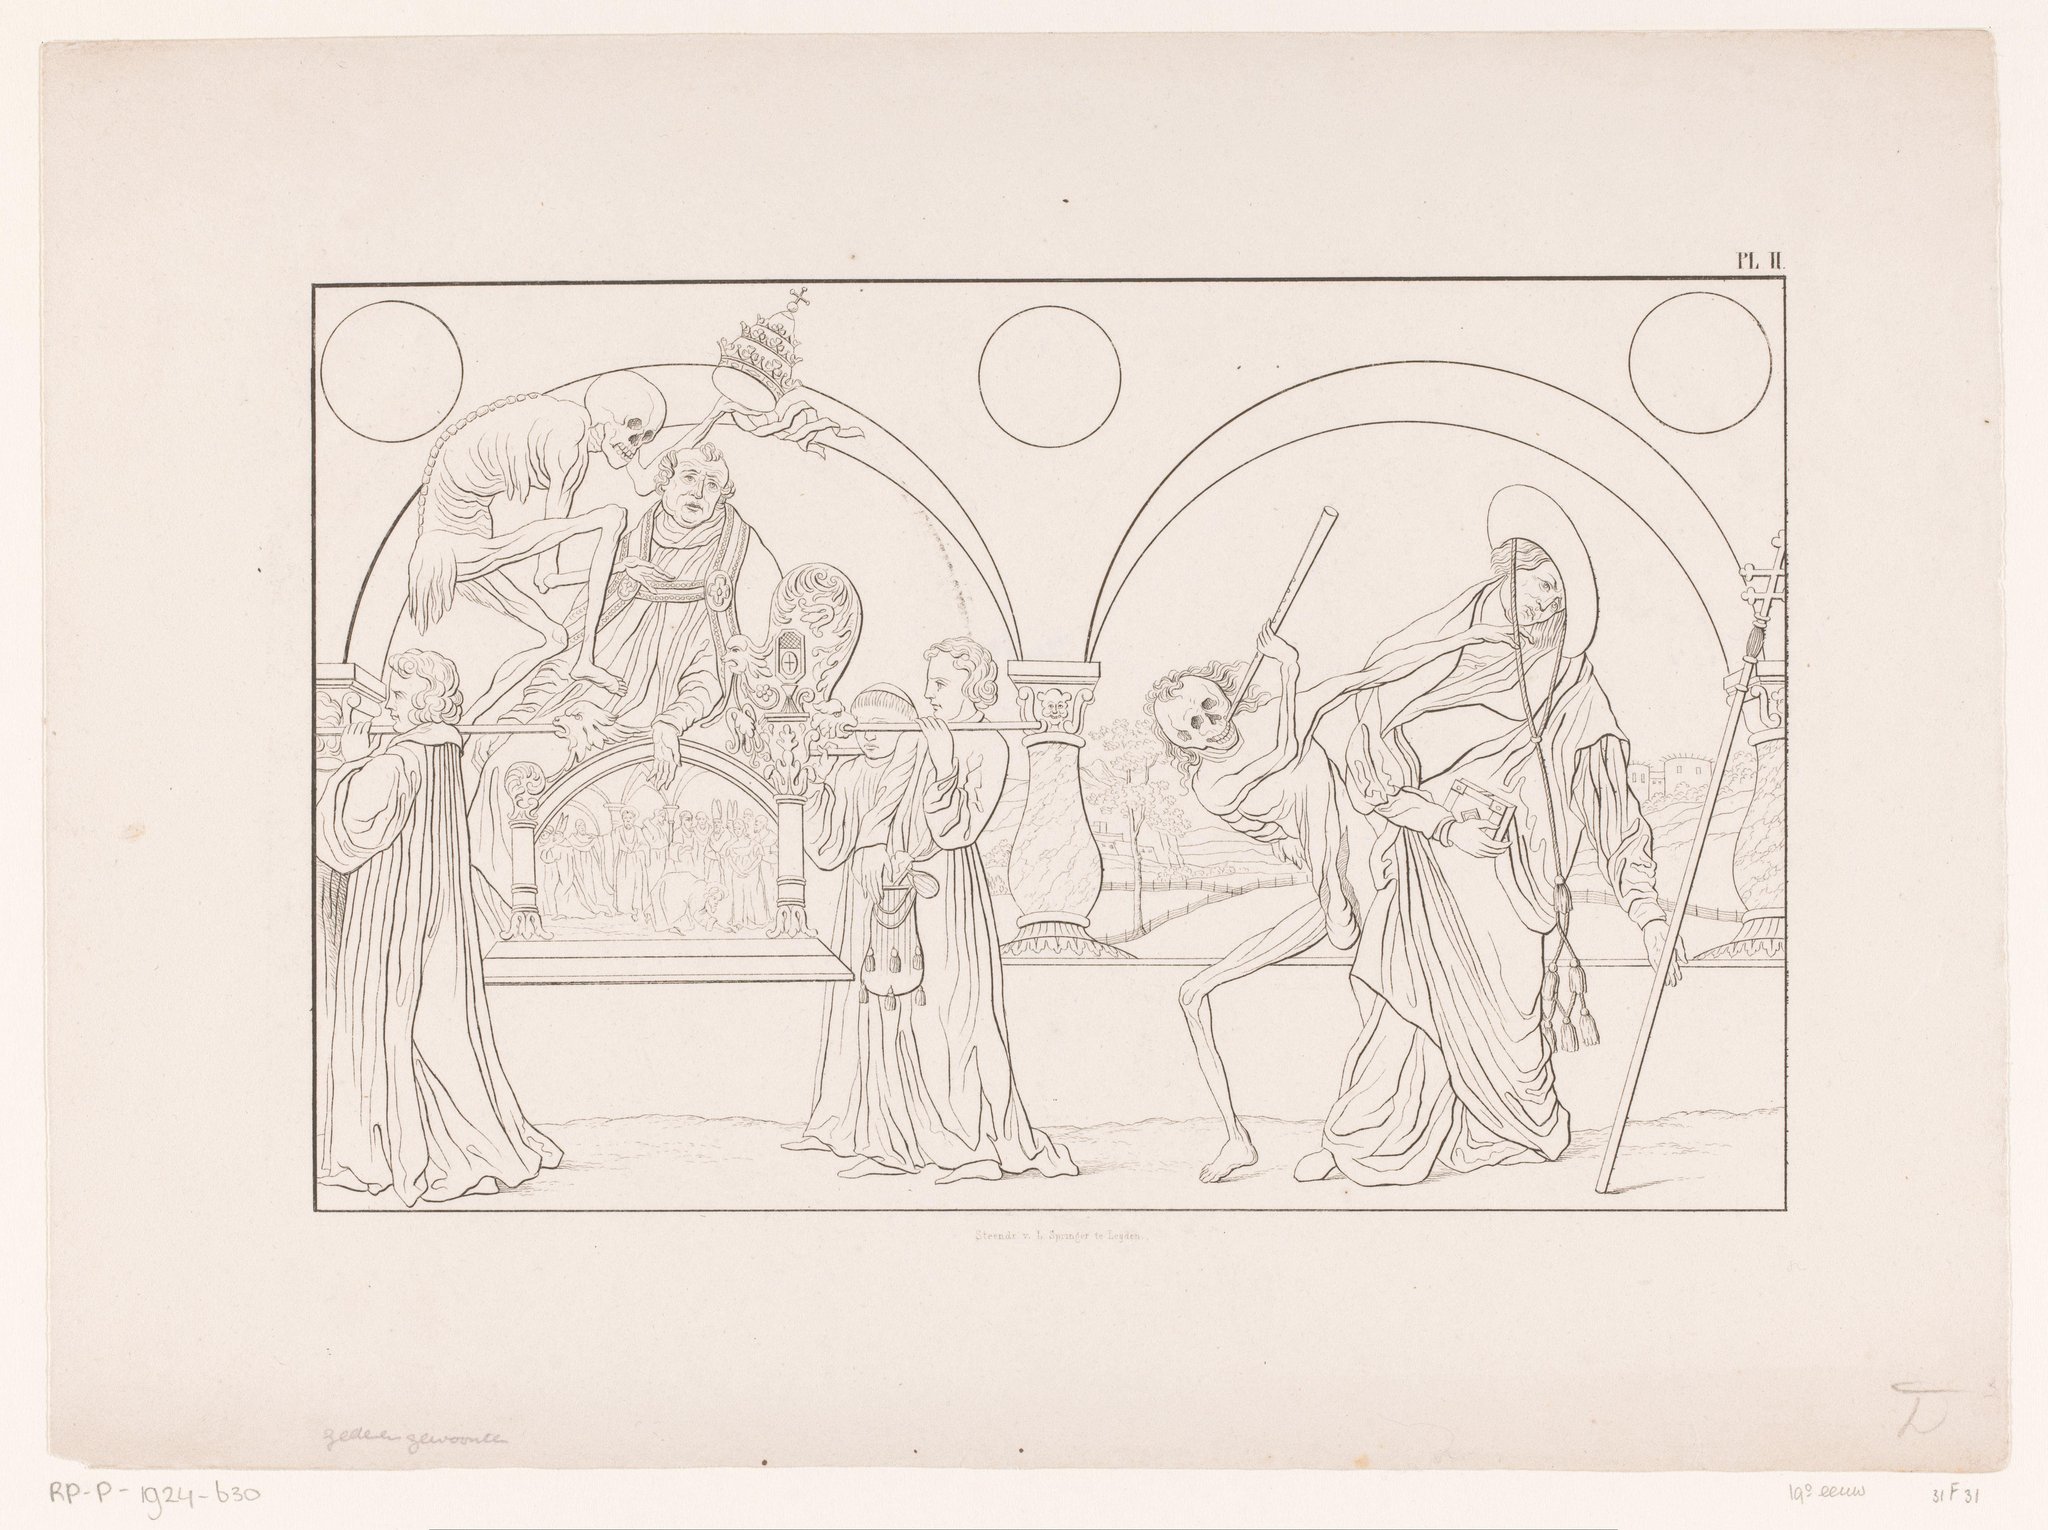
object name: print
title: Dodendans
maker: leendert springer (i)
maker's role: draughtsman, painter, print maker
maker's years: 1789-1871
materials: paper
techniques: lithograph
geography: leiden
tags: dance of death; death together with one or more human beings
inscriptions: collector's mark: Lugt 2233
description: Prent uit: Kist, N.C, 'Het humoristisch karakter der christelijke kunst in het tijdvak, hetwelk de kerkhervorming der XVIde eeuw heeft voorbereid; zigtbaar vooral in de kerkelijke architectuur en de doodendansen', Nederlandsch archief voor kerkelijke geschiedenis 4 (1844).